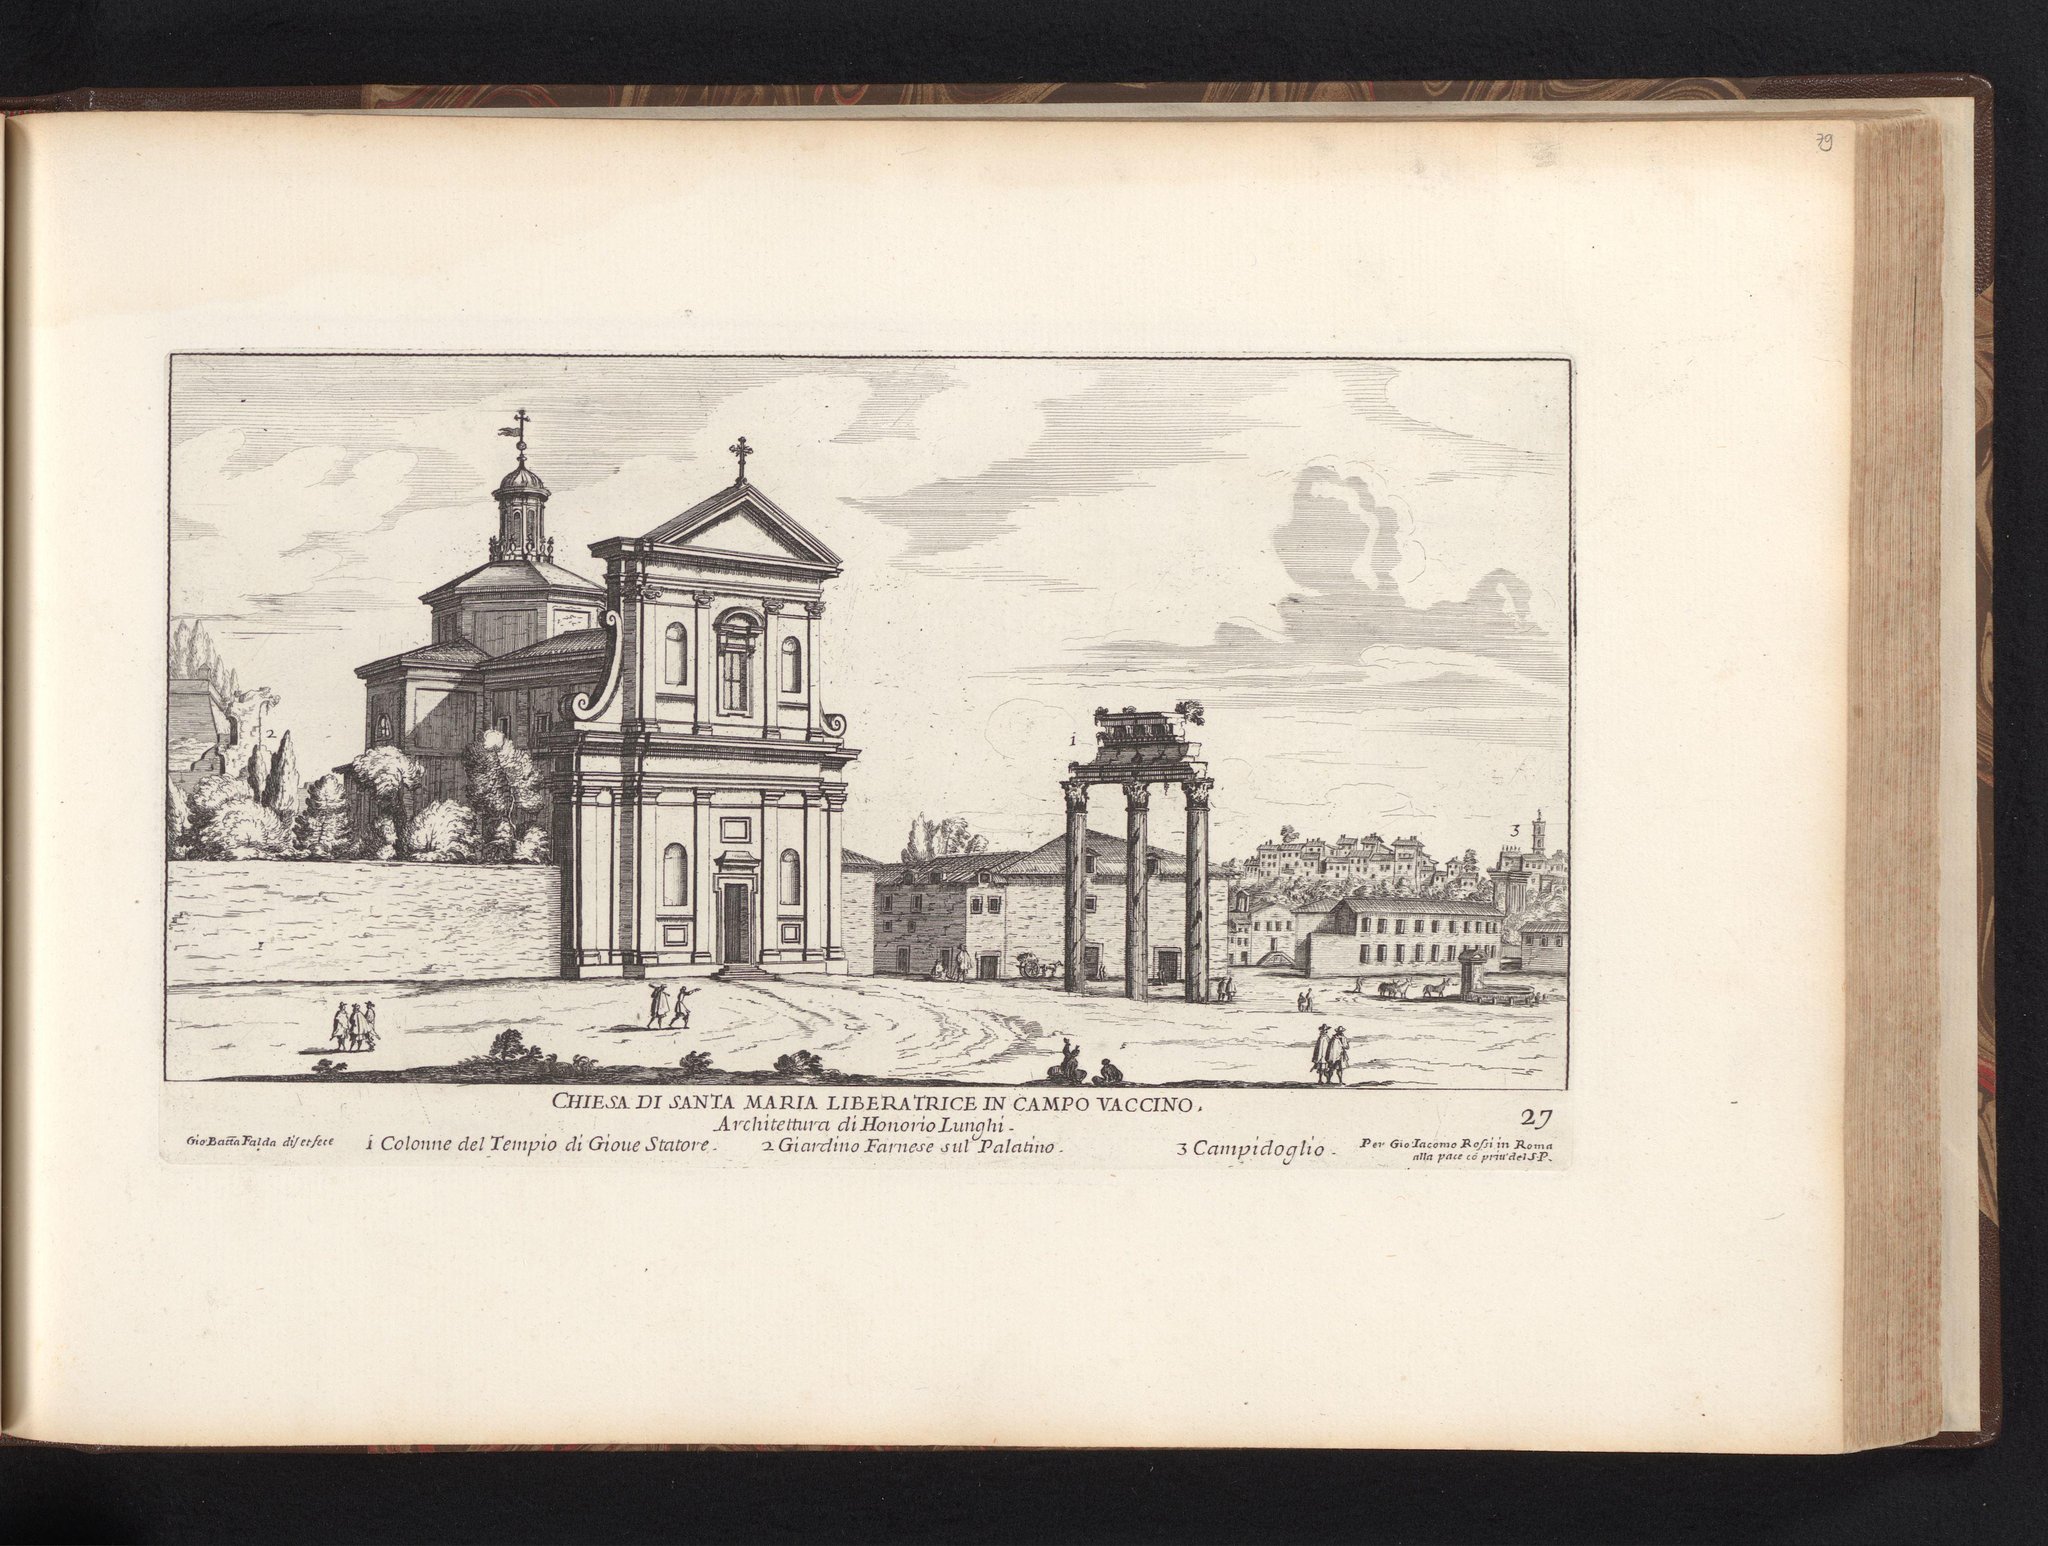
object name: print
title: Il terzo libro del'novo teatro delle chiese di Roma date in luce sotto il felice pontificato di nostro signore papa Clemente IX (...) (libro terzo)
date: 1669-1670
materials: paper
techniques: etching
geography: rome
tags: city-view, and landscape with man-made constructions, church (exterior)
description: Deze titelprent maakt deel uit van een reeks van 38 prenten met voorstellingen van kerken in Rome. Samen met vier andere reeksen vormt het de grote reeks: 'Il nuovo teatro di Roma moderna'.